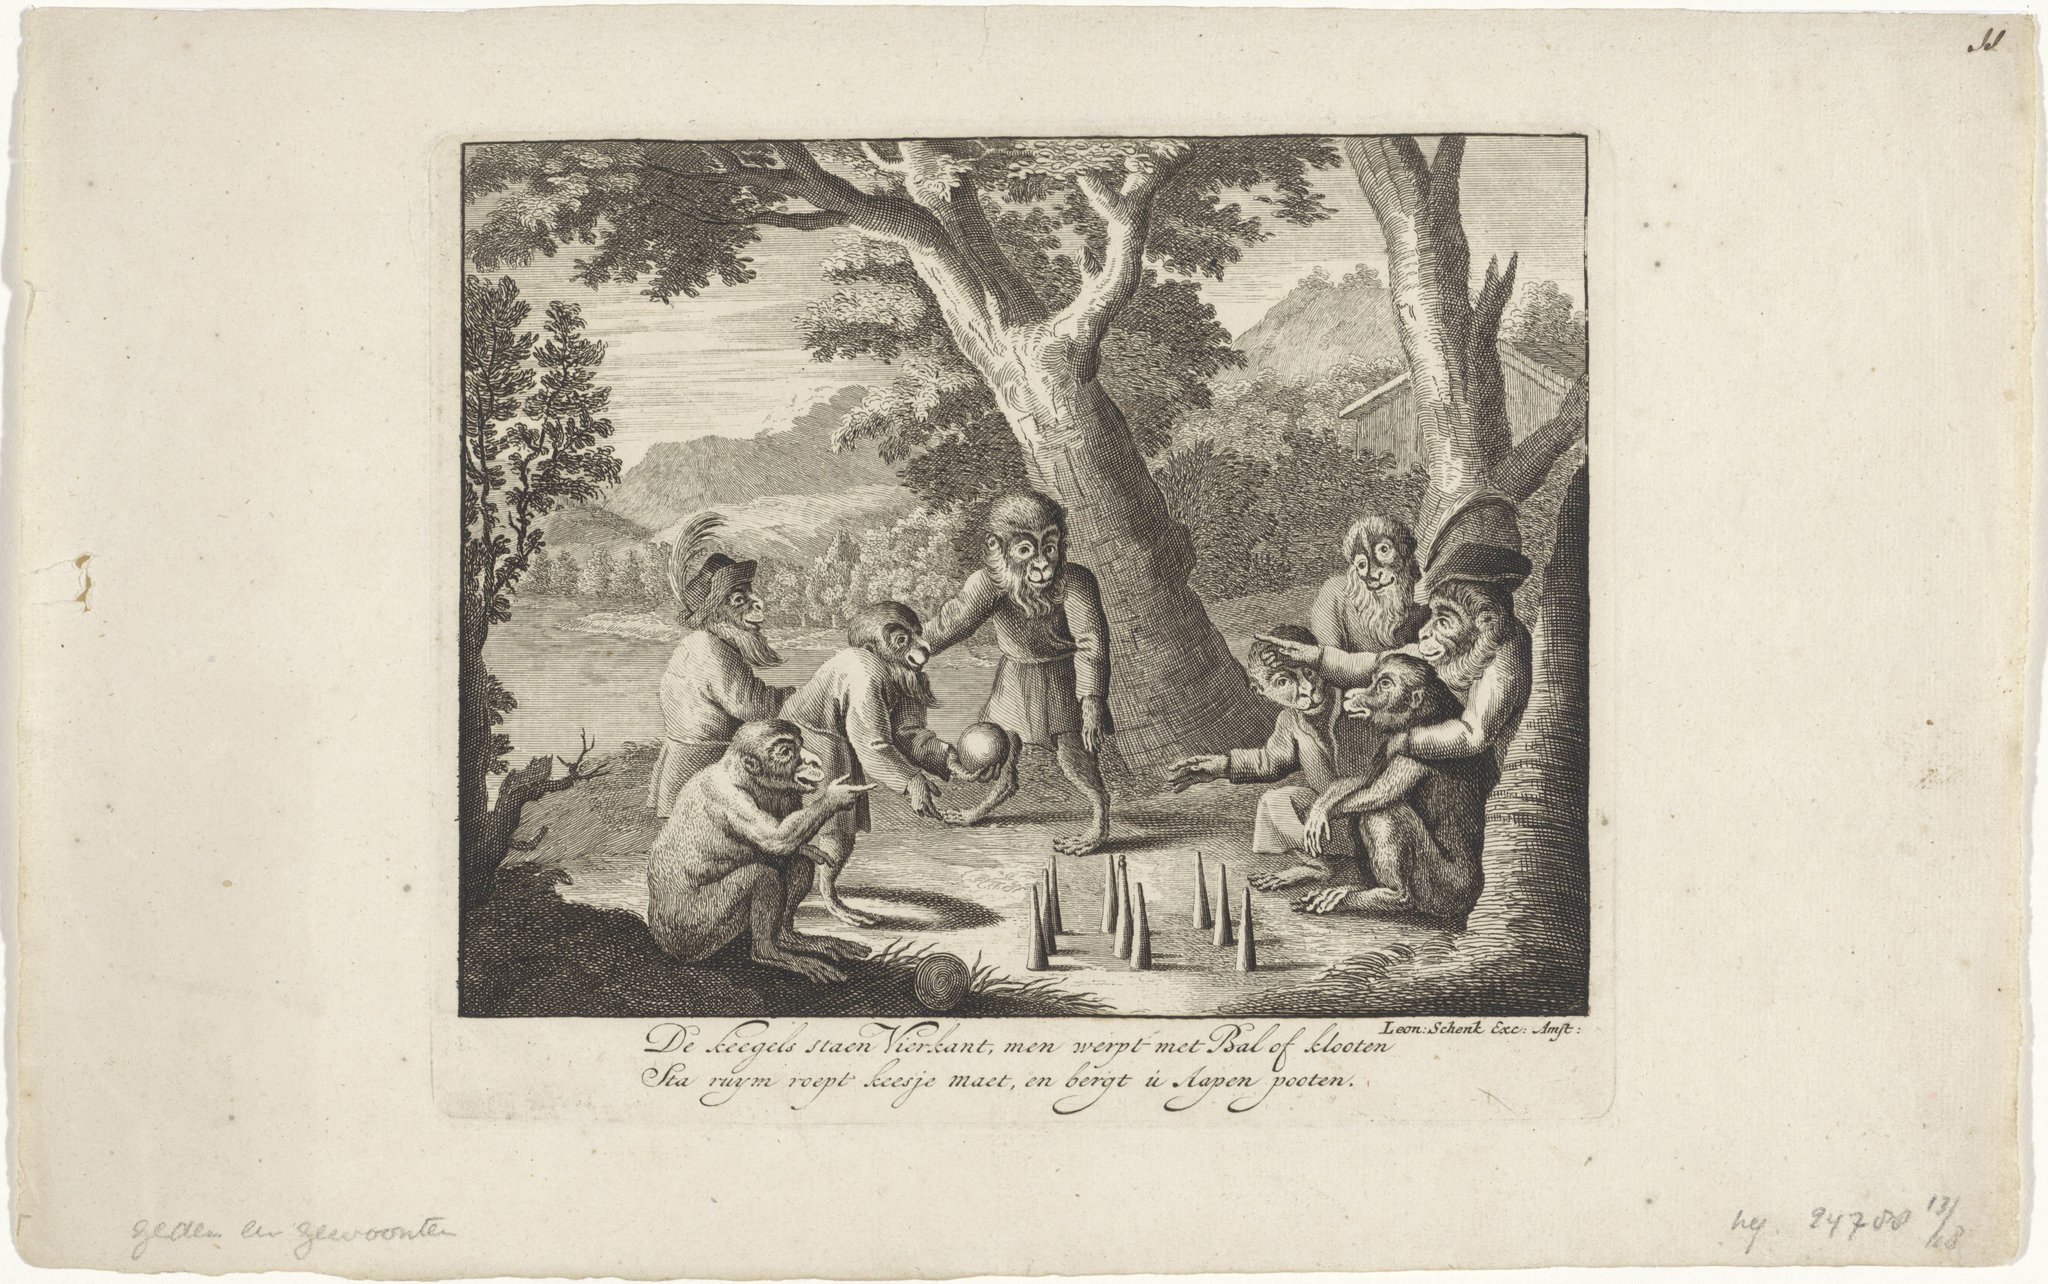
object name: print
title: Apen spelen het kegelspel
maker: leonard schenk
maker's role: print maker, publisher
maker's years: 1696-1767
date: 1720-1767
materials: paper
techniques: etching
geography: amsterdam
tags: monkeys, apes, animals acting as human beings, ninepins, skittles (+ out of doors (sports, games, etc.))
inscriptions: collector's mark: Lugt 2228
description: Landschap met kegelende apen. Enkelen van hen kijken vanonder een boom toe. Onderdeel van een serie bestaande uit een titelprent en platen waarin apen als mensen figureren in allerlei taferelen uit het dagelijks leven. De prent heeft een tweeregelig vers in het Nederlands.